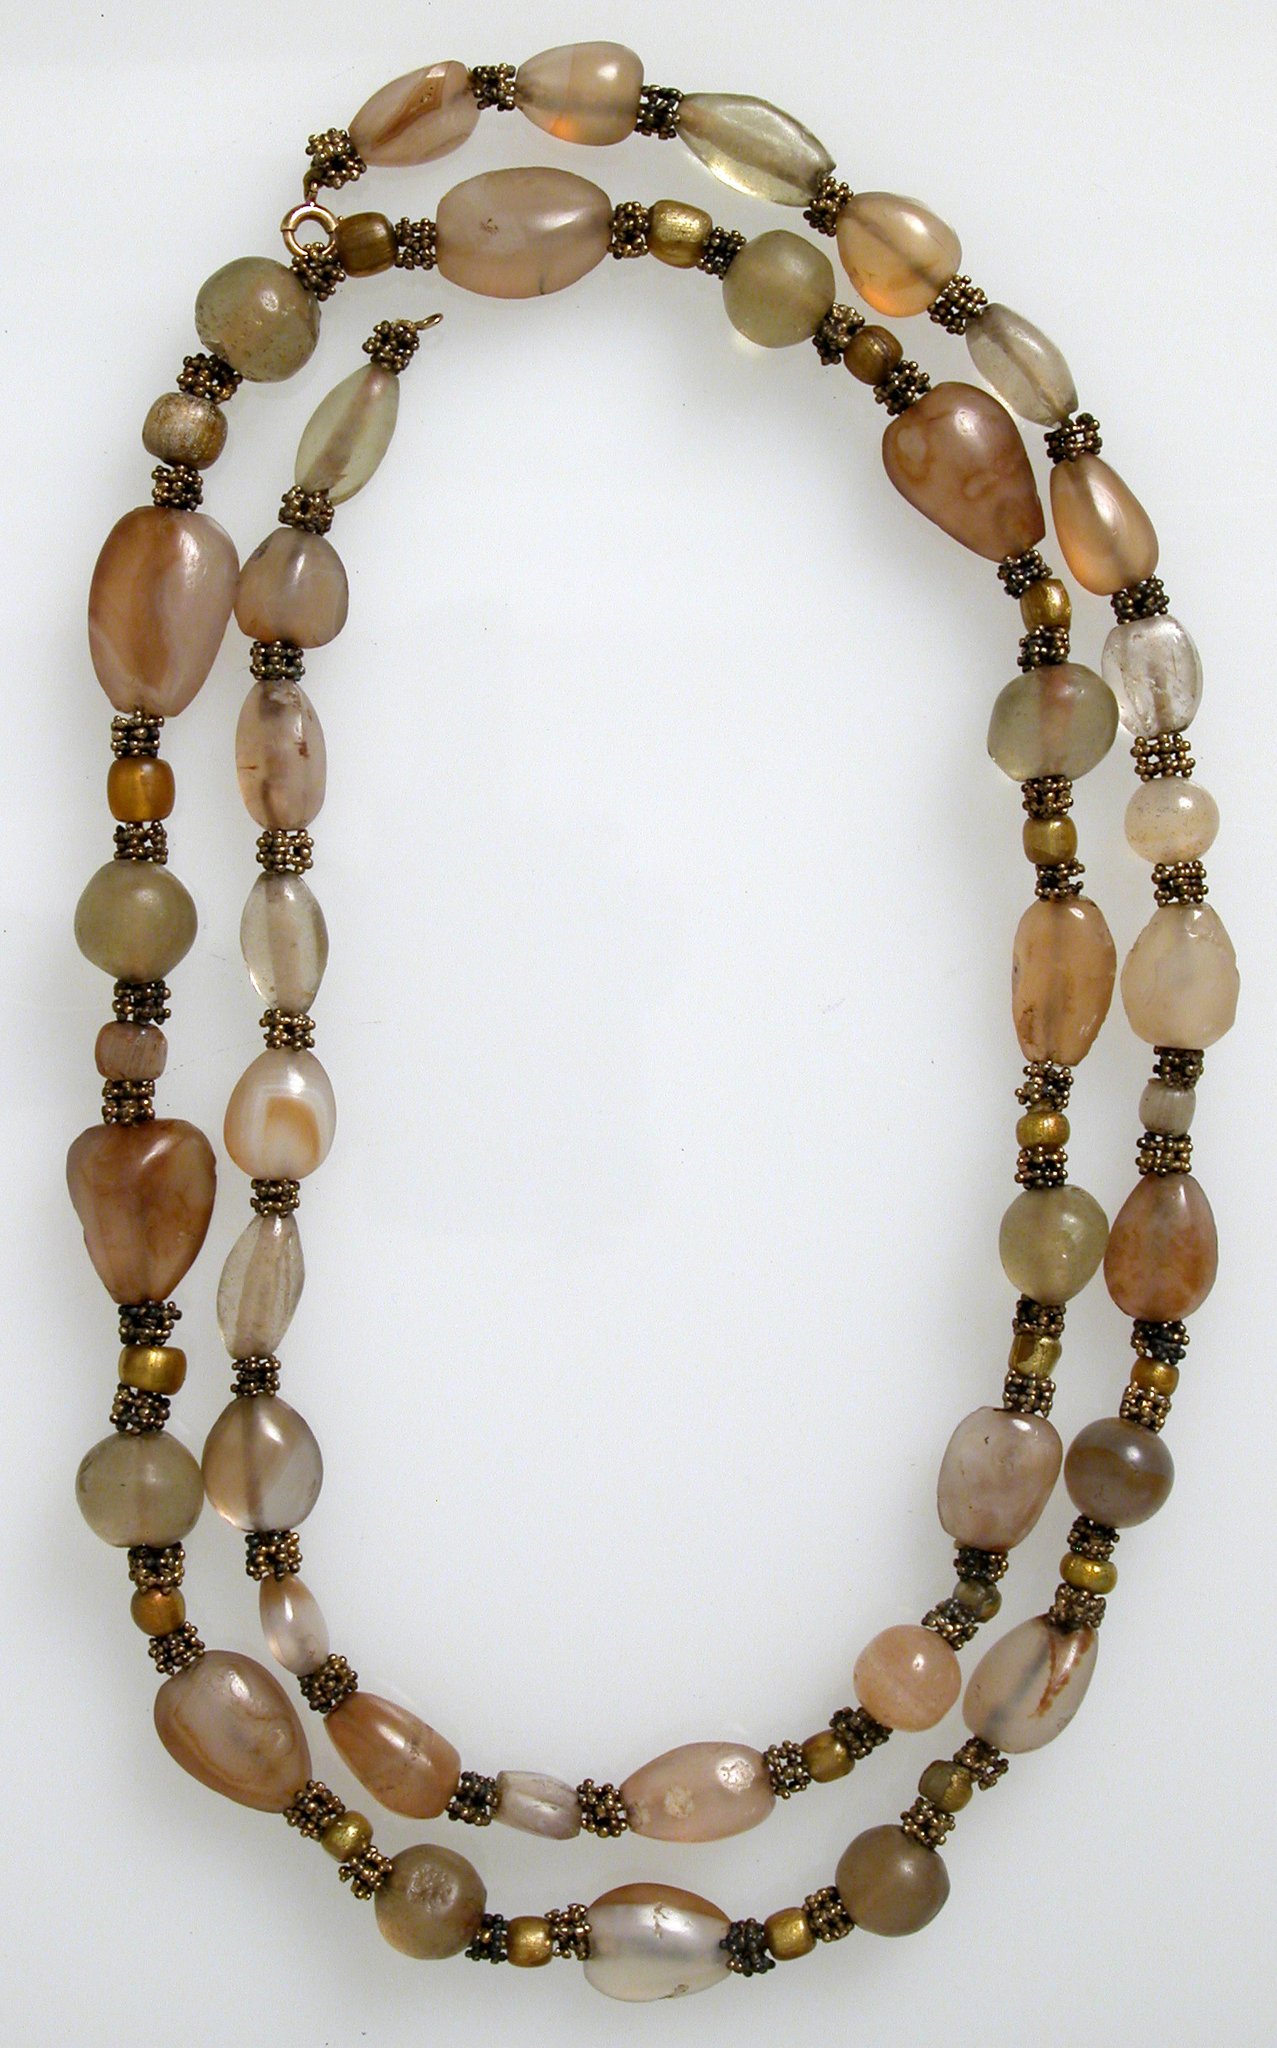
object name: bead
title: Beads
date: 301-500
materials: stone, quartz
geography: egypt